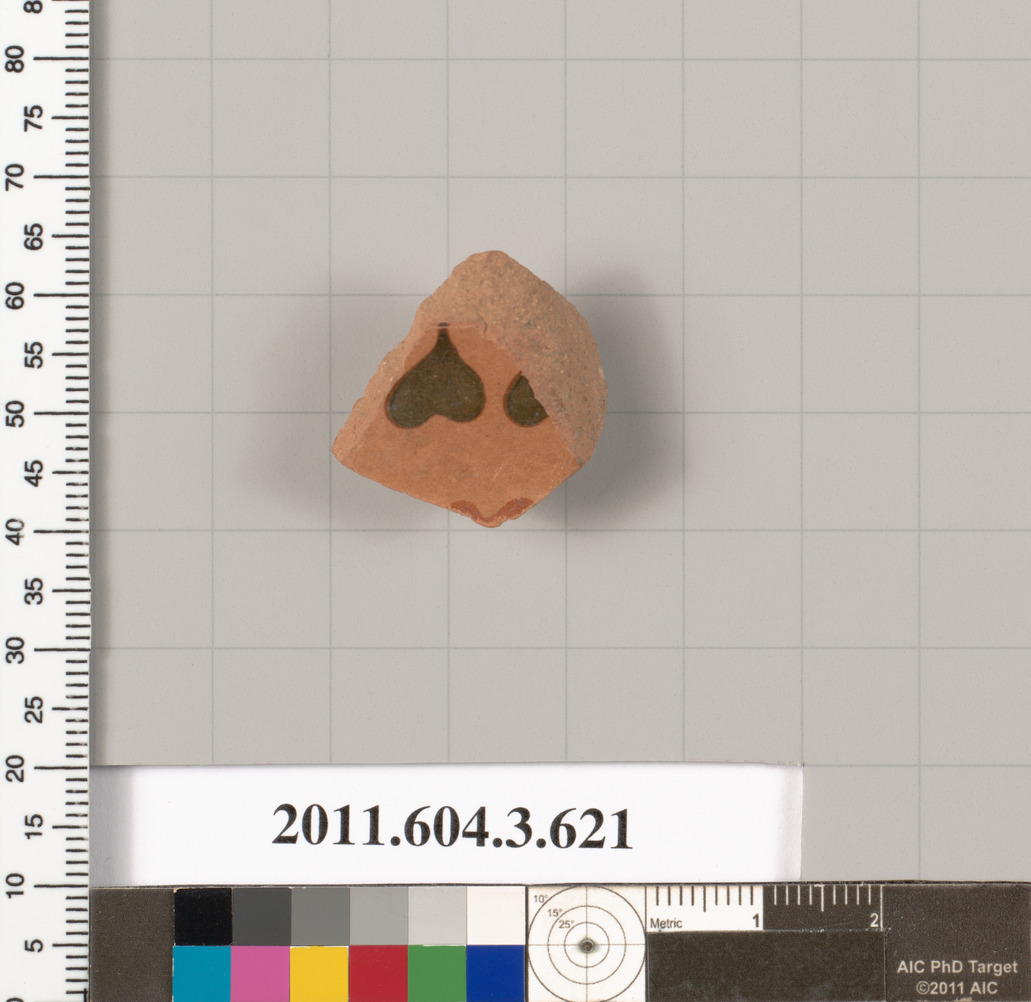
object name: calyx krater fragment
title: Terracotta fragment of a calyx-krater (bowl for mixing wine and water)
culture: greek, attic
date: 525-501 BCE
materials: terracotta